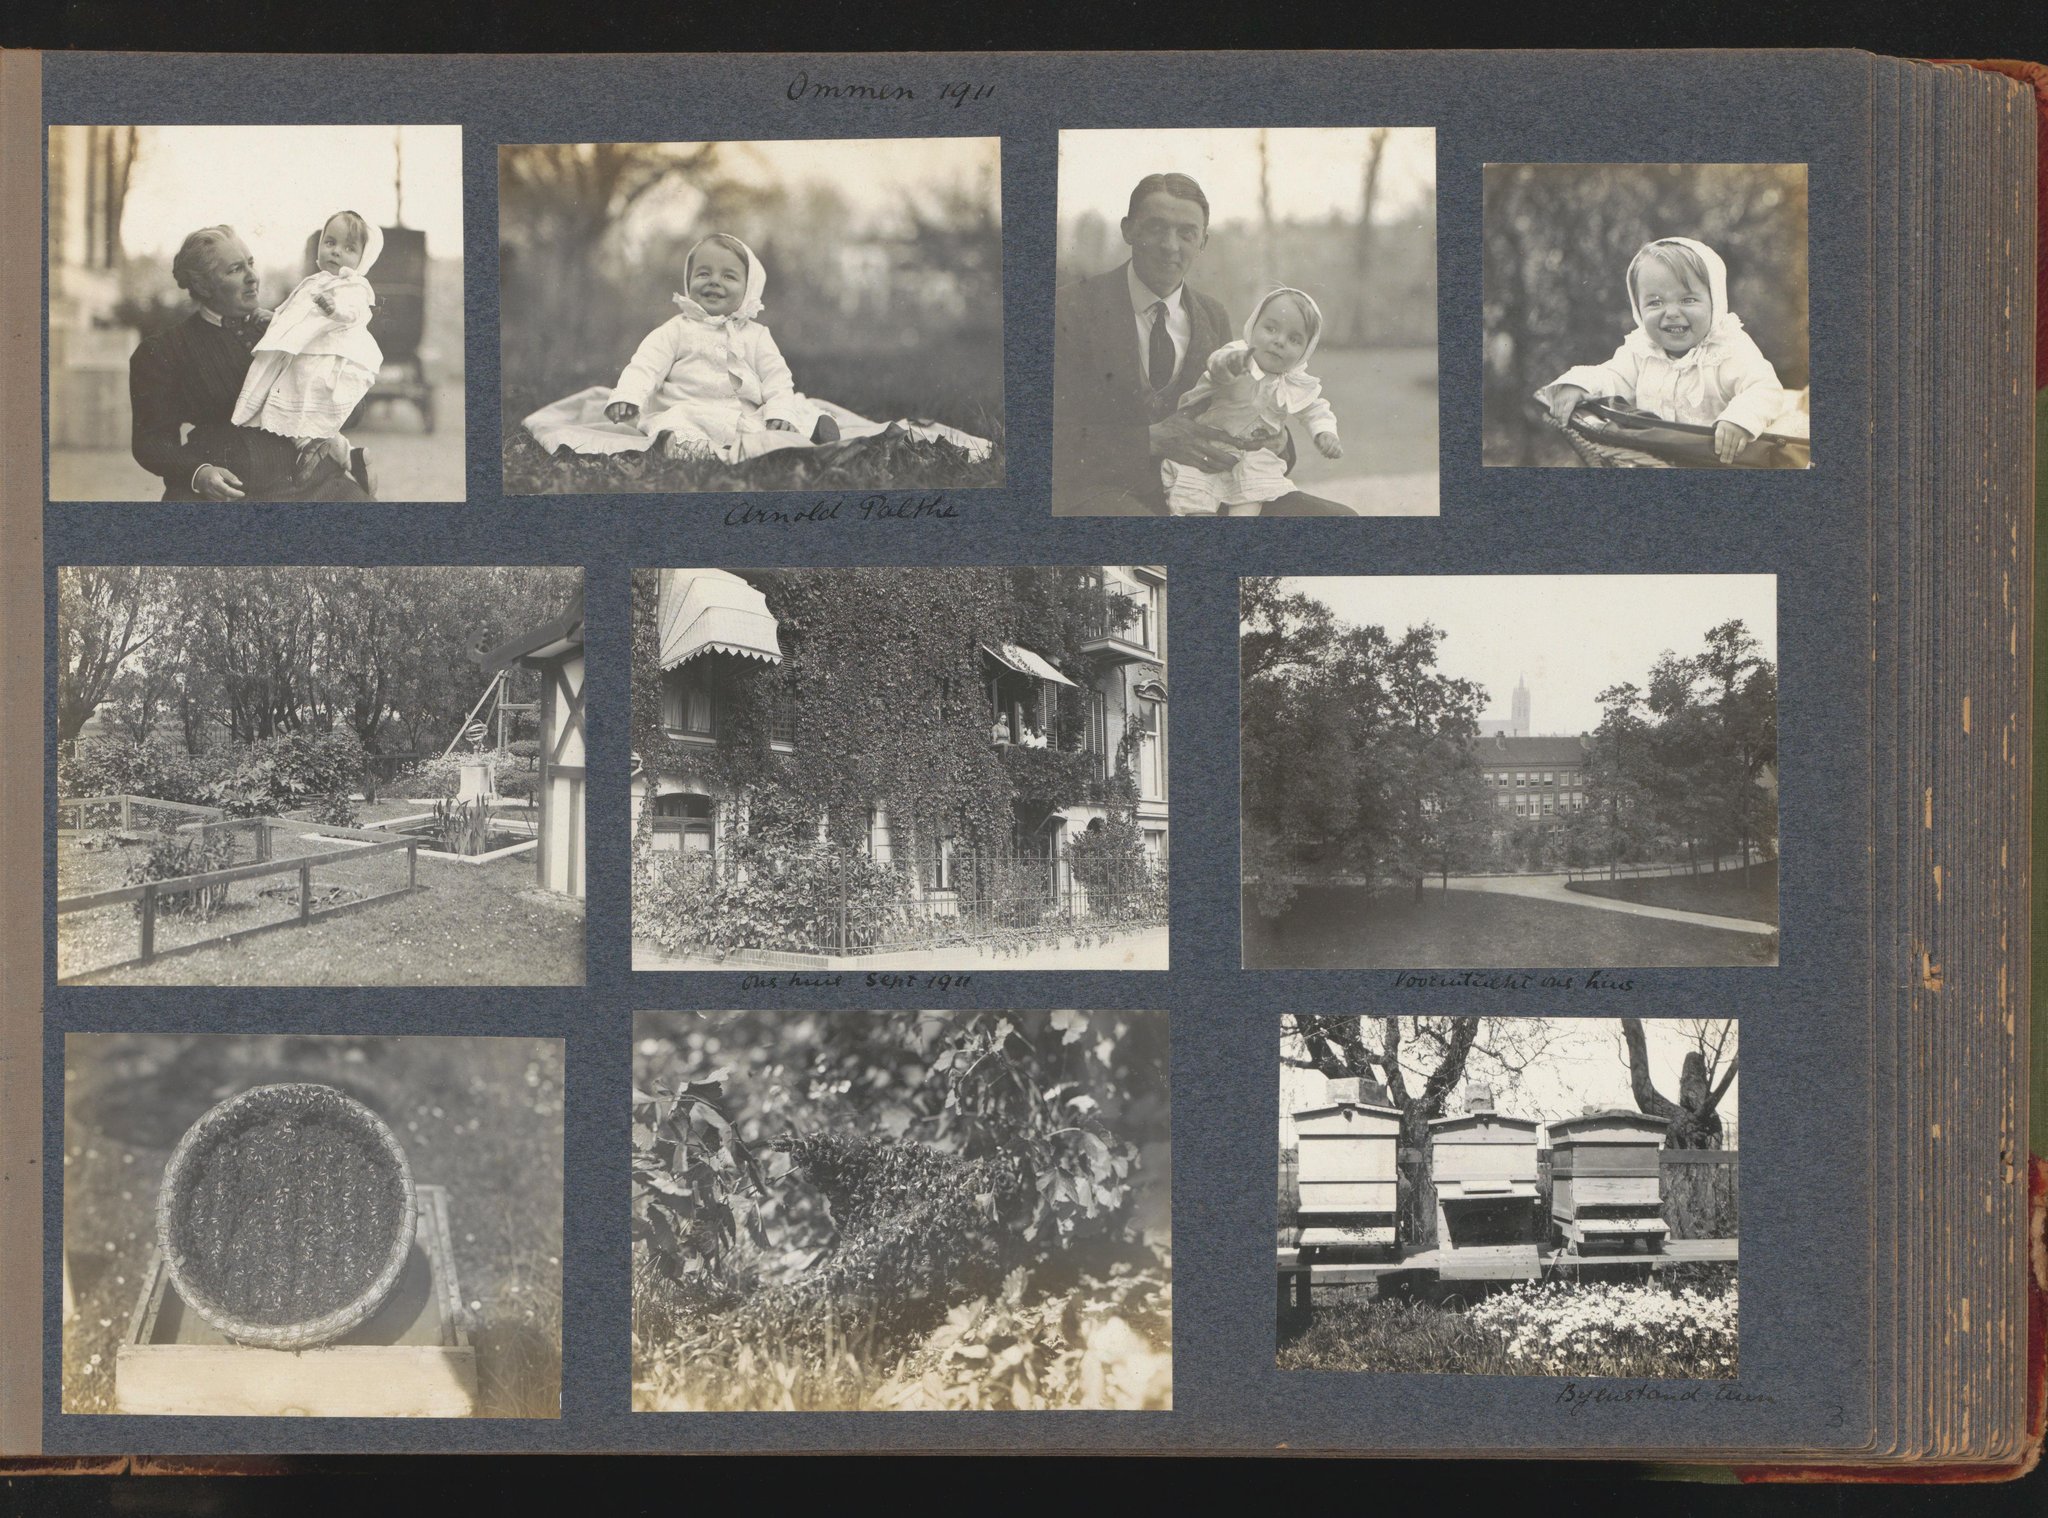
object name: photograph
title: Arnold Palthe en woonhuis in Ommen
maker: Anonymous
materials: cardboard, paper, photographic support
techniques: gelatin silver print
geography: ommen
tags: rural housing, e.g. country-house, villa, cottage, bee-hive, insects: bee, tot, toddler ~ the ages of man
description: Albumblad met tien foto's van Arnold Palthe als kleuter en van een woonhuis met tuin en uitzicht op de Brigittakerk in Ommen. Ook opnames van een bijenkorf. Onderdeel van Fotoalbum van de familie Palthe uit Almelo.